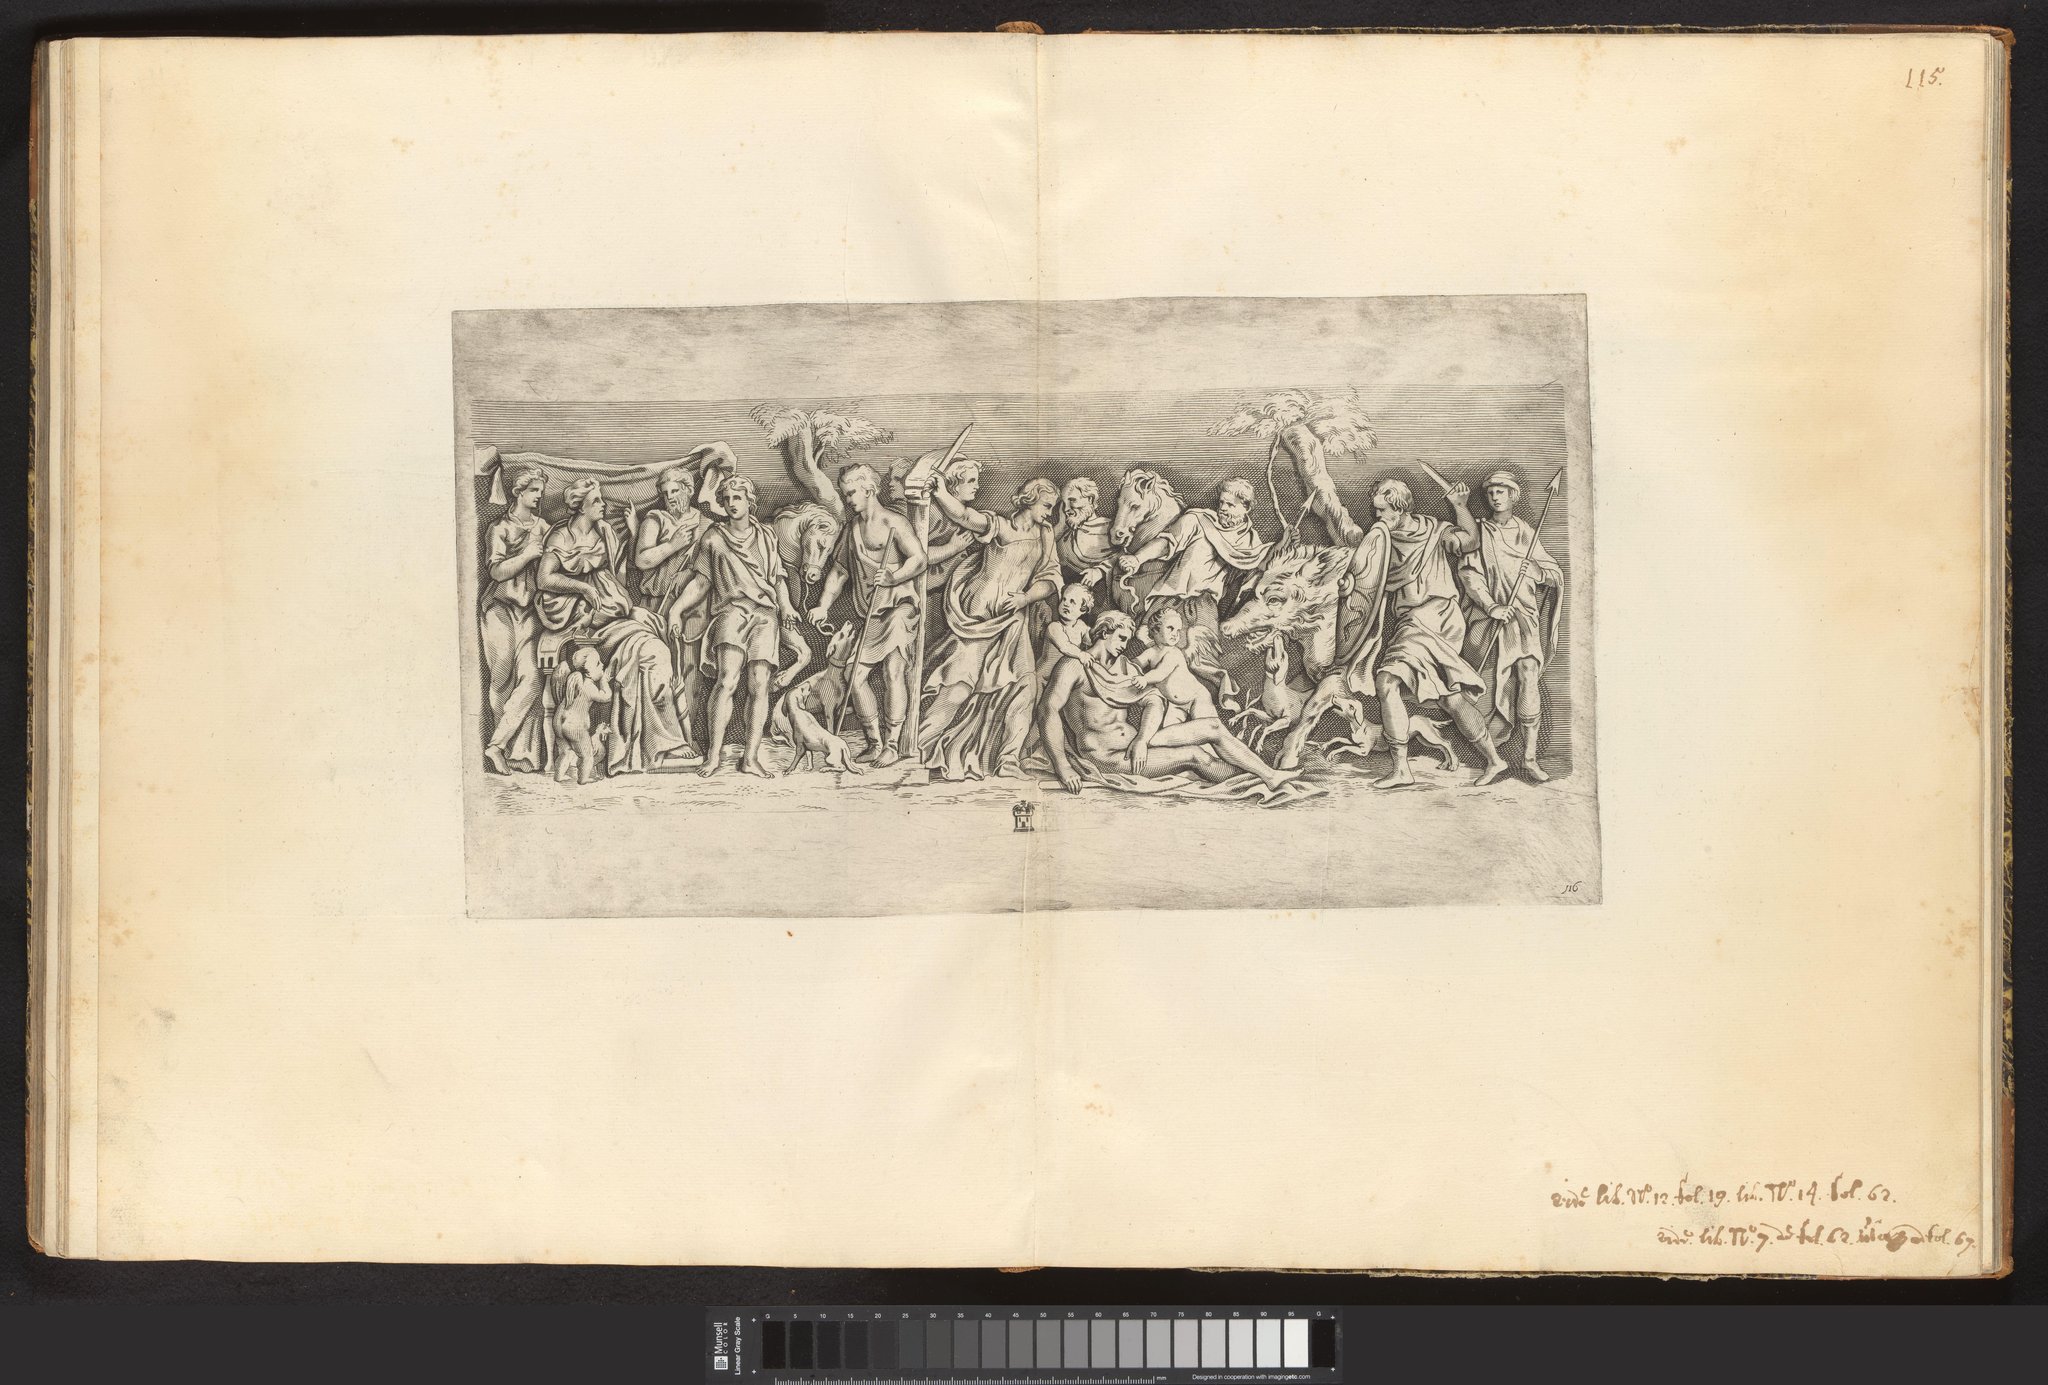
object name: print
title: Galleria Giustiniana del Marchese Vincenzo Giustiniani II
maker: michel natalis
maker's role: print maker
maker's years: 1610-1668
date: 1636-1647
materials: paper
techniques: engraving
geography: rome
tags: piece of sculpture, reproduction of a piece of sculpture, foliage, tendrils, branches ~ ornament, cupids: 'amores', 'amoretti', 'putti'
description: Bas-reliëf met een putto die deels bestaat uit gebladerte. Zijn vleugels en benen worden gevormd door gebladerte. Midden onder het wapenschild van Vincenzo Giustiniani. Prent maakt deel uit van een album met een serie prenten naar de sculpturen in de verzameling in de Galleria Giustiniani te Rome.